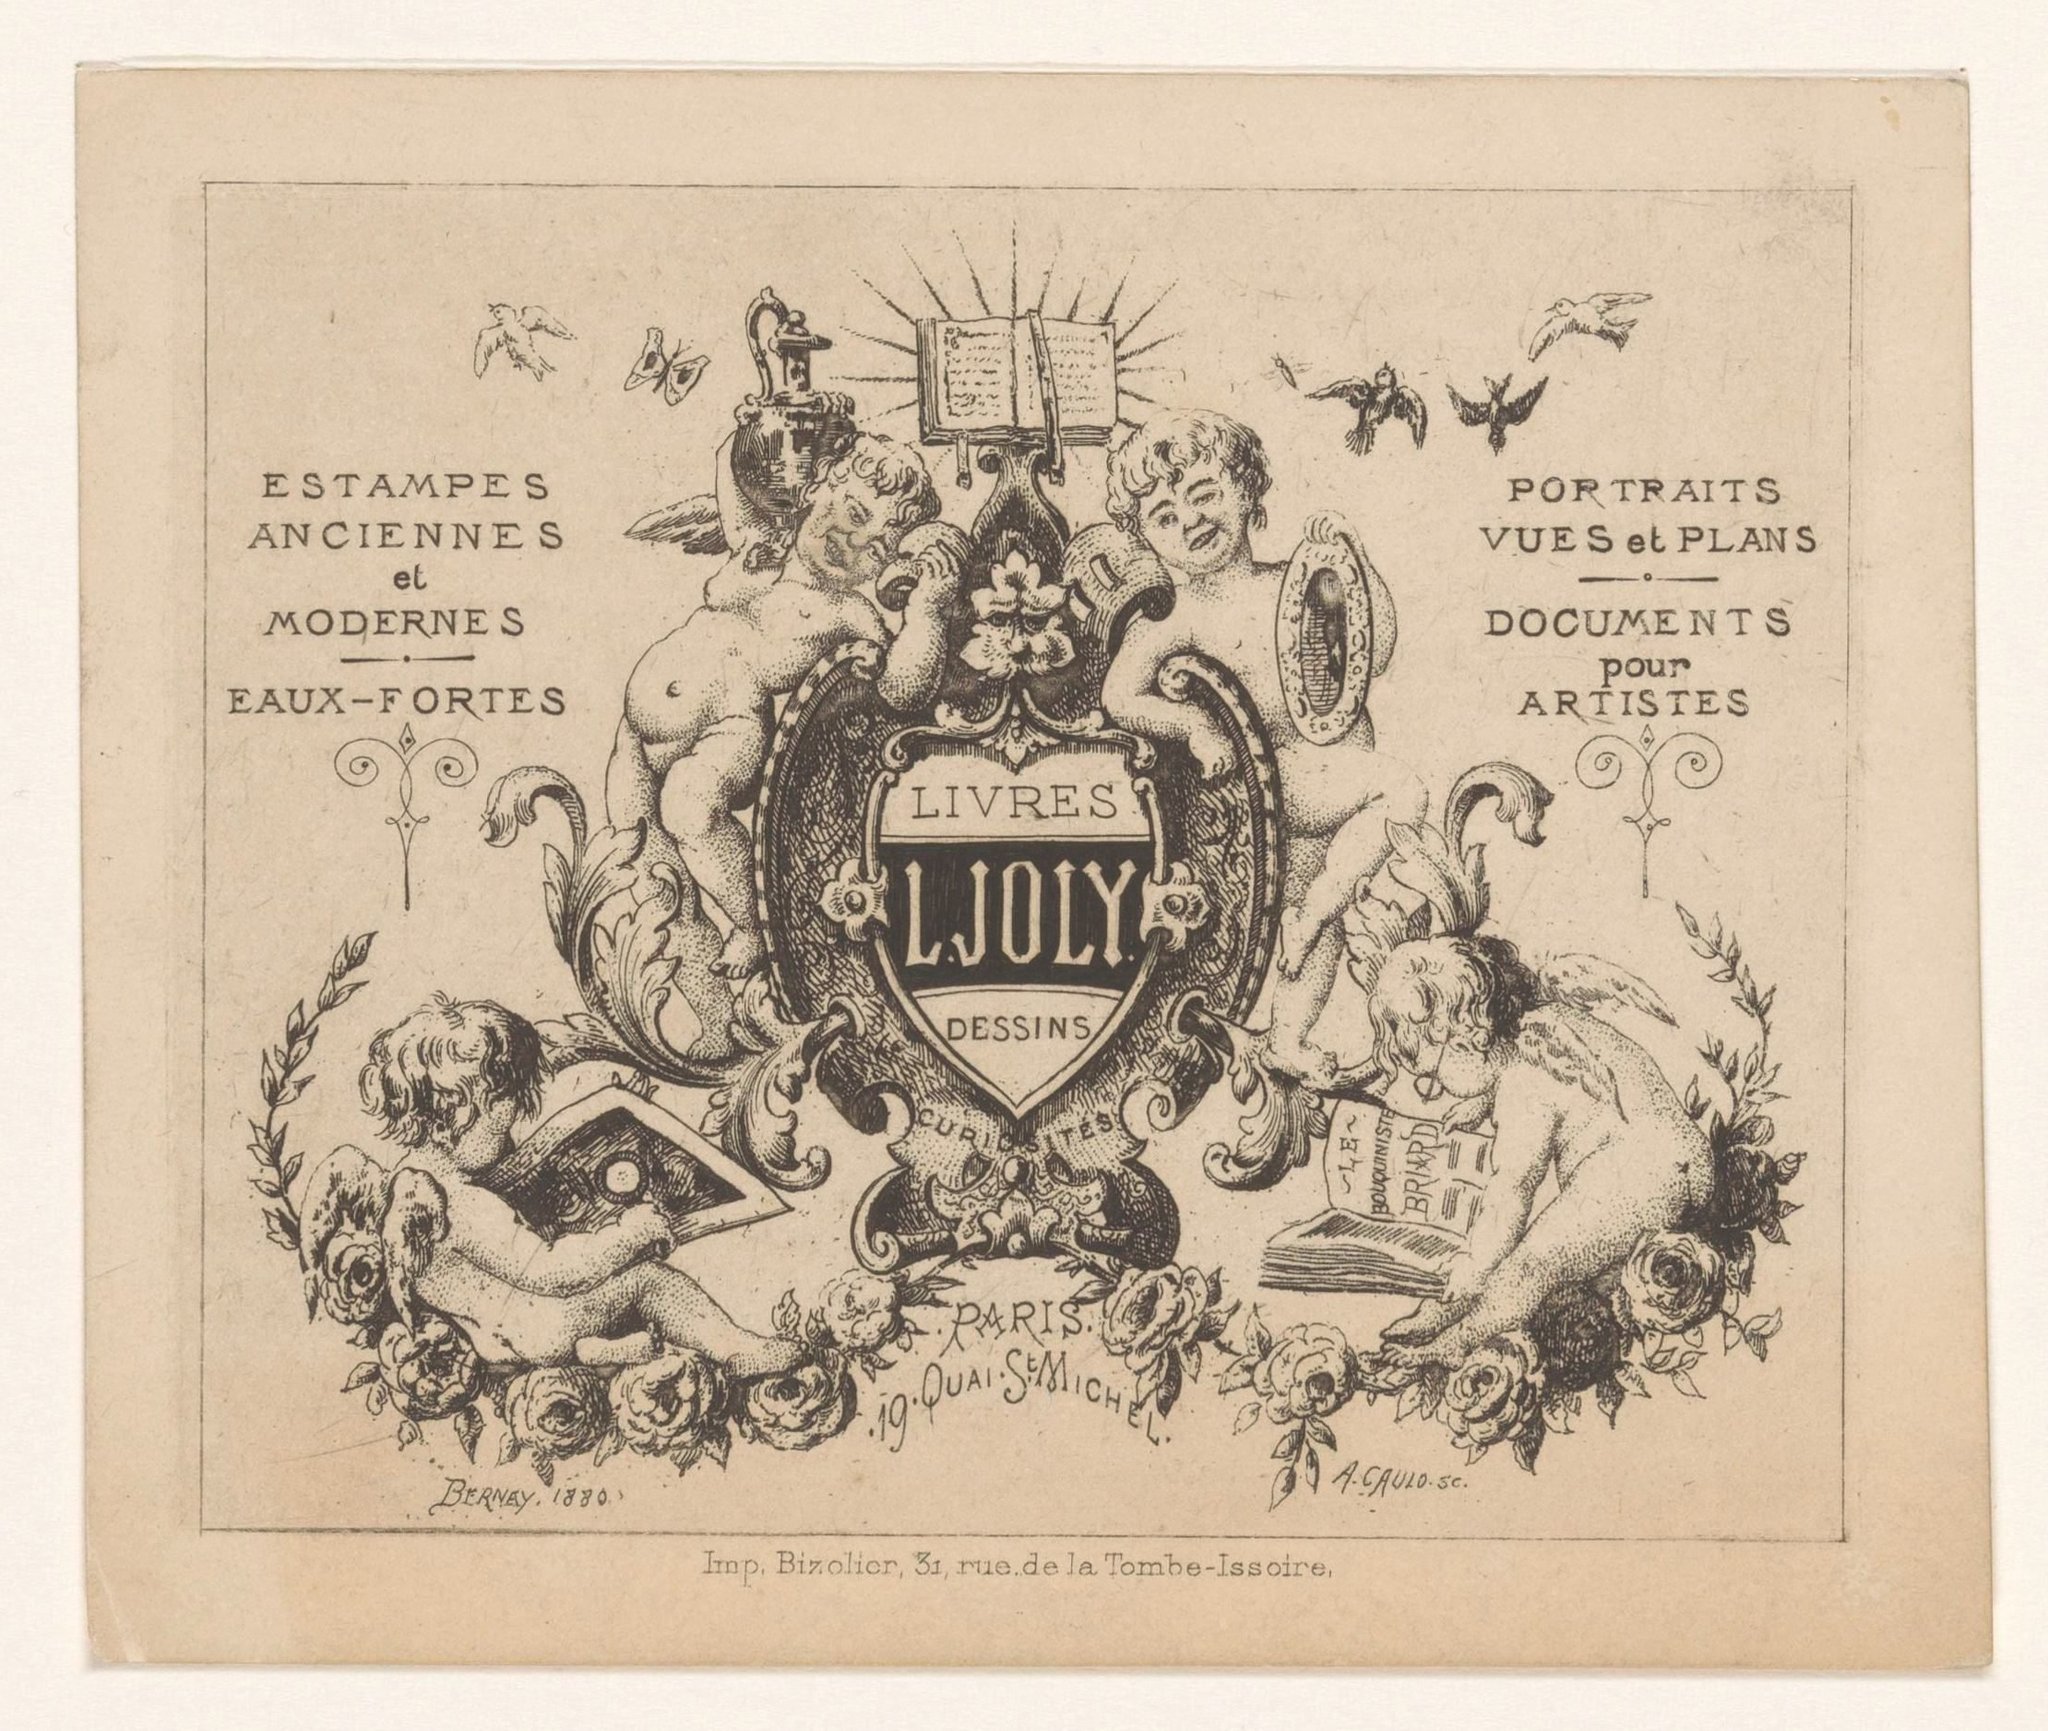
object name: print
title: Visitekaartje van boek- en prenthandel van L. Joly te Parijs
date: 1880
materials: paper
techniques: etching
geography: paris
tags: book, cupids: 'amores', 'amoretti', 'putti', book-shop, bookseller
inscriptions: collector's mark: Lugt 2228, collector's mark: Lugt 4779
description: Twee putti ondersteunen een cartouche bekroond met een boek, de een met een vaas, de ander met een spiegel. Onderin twee putti gezeten op een bloemenkrans, de een bestudeert een prent met een vergrootglas, de ander bekijkt een boek.